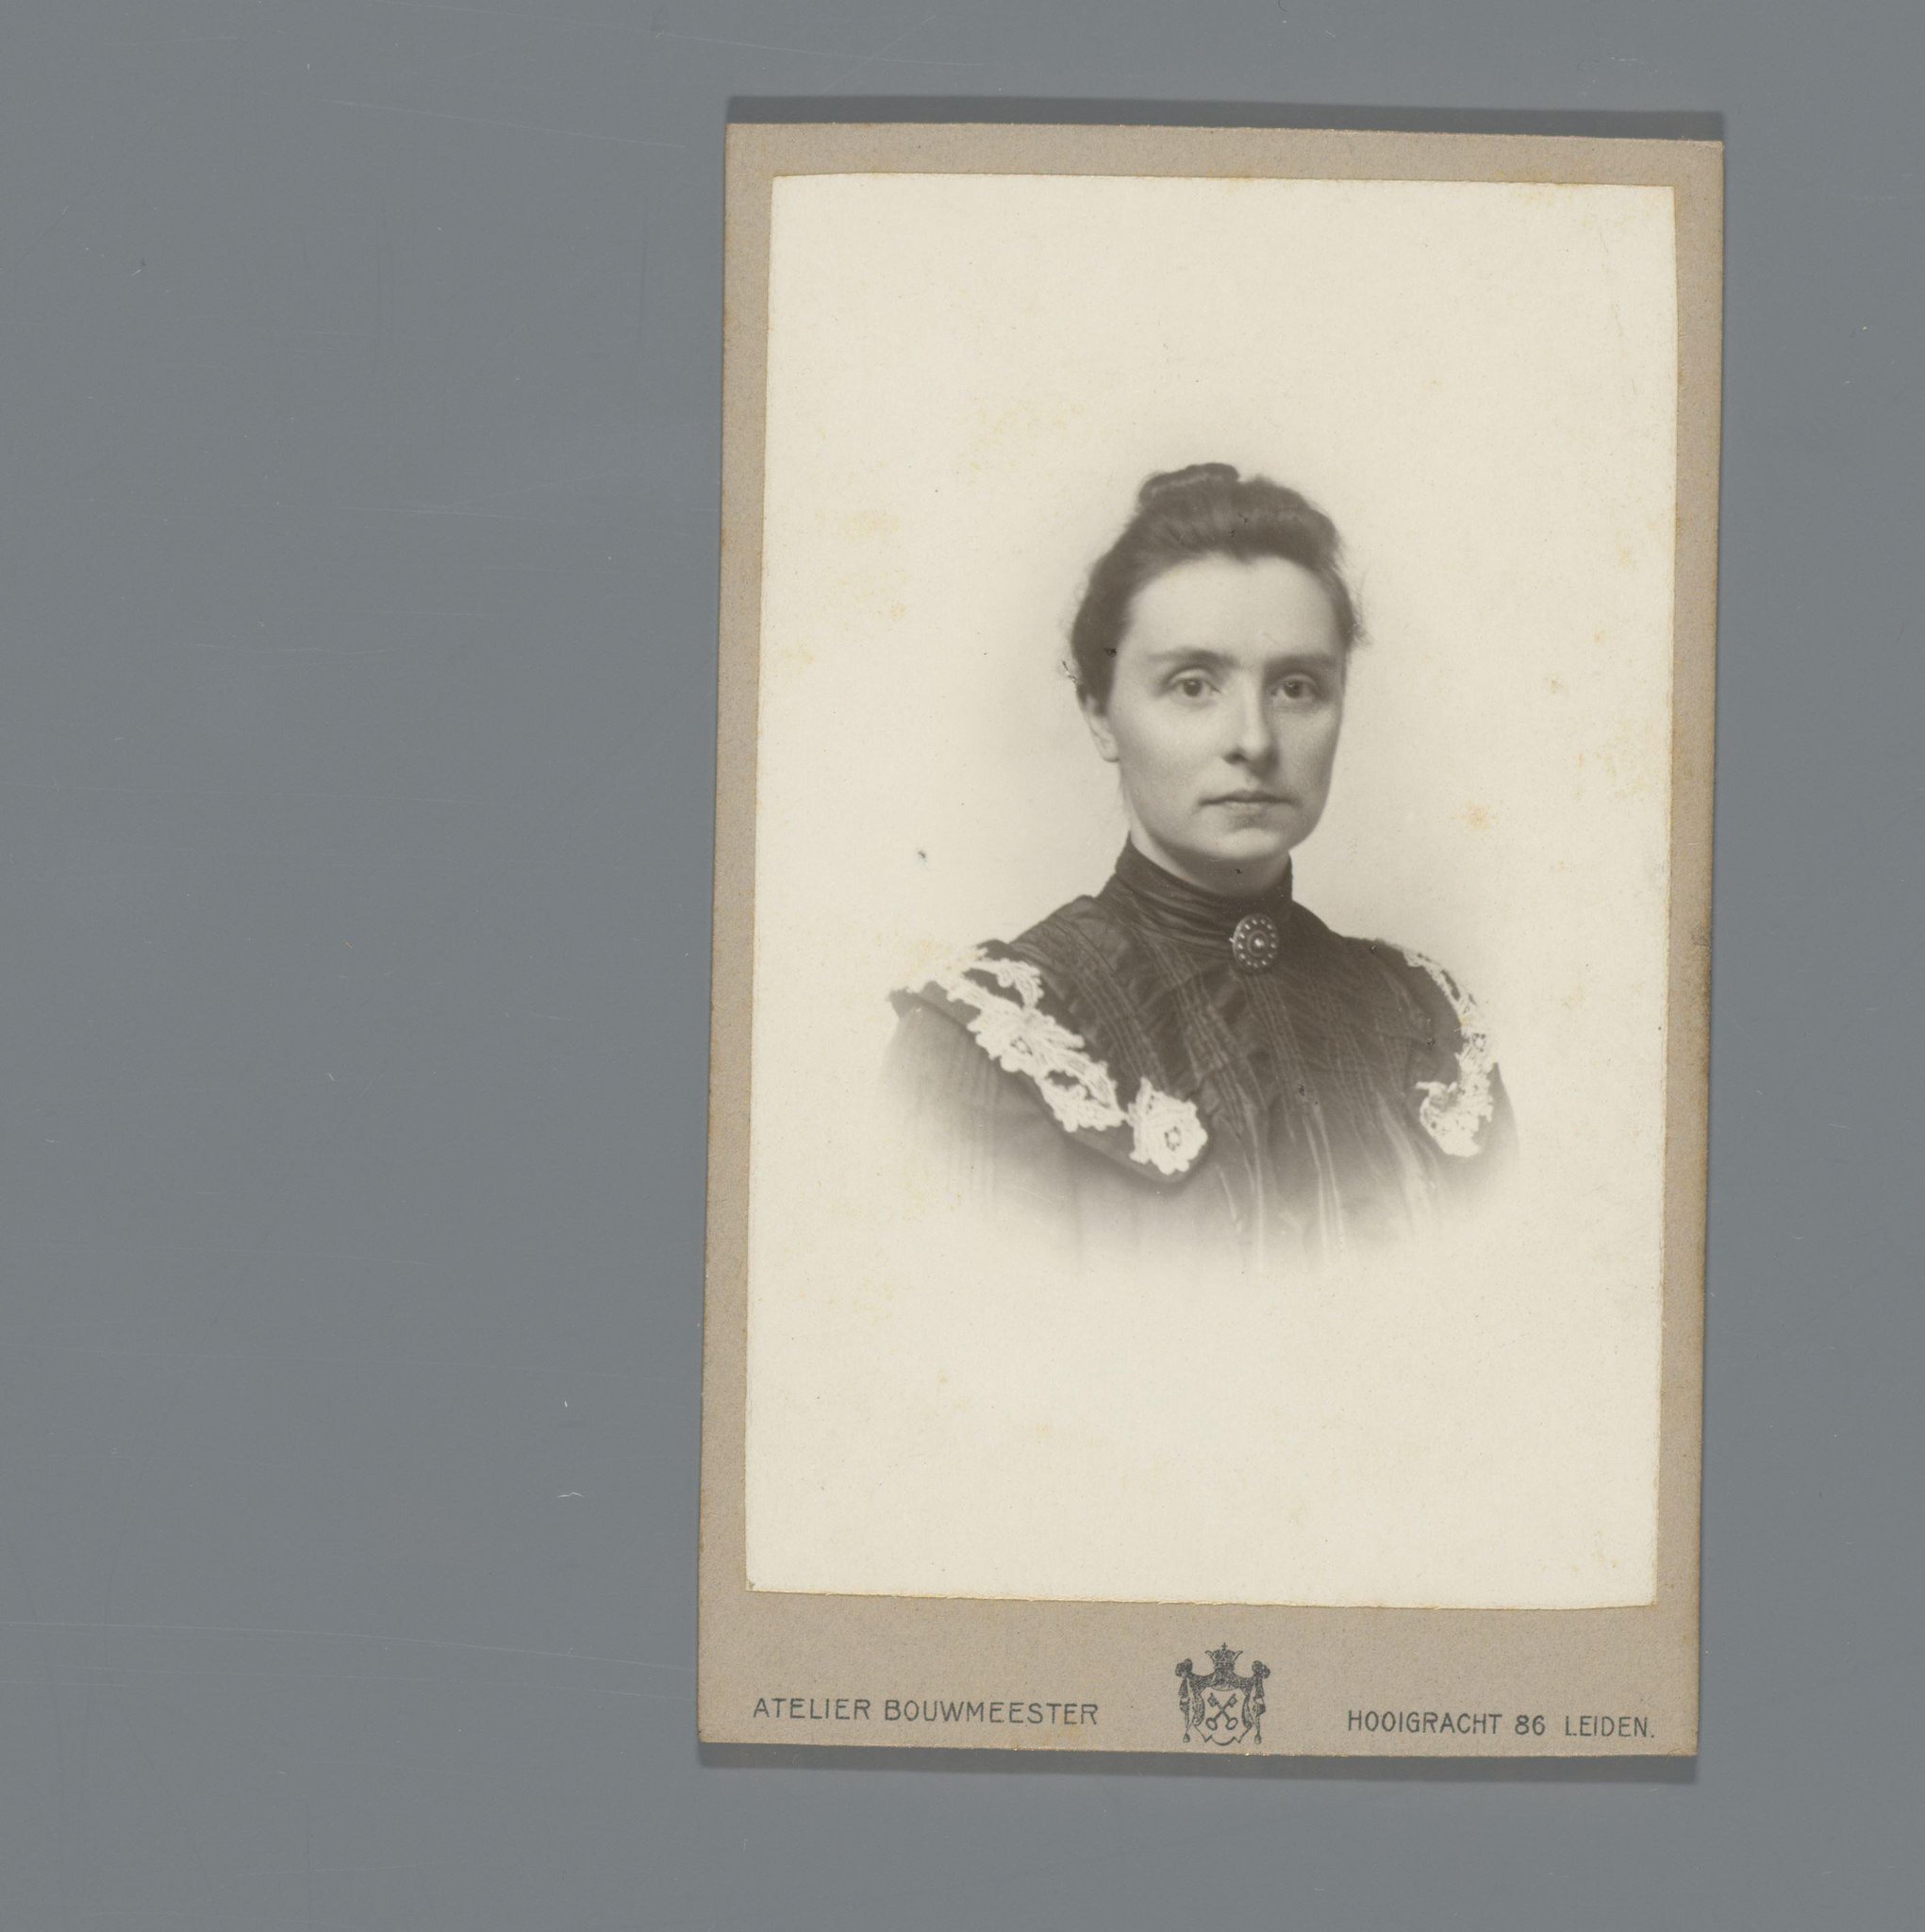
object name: photograph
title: Portret van Anna van Gogh-Kaulbach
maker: thomas johannes bouwmeester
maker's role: fotograaf, retoucheur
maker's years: 1861-1942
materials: cardboard, photographic support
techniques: collodion silver print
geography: leiden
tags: haarlem, portrait of a writer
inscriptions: inscription: ‘ATELIER BOUWMEESTER/ LEIDEN.’, annotation: ‘A. van Gogh-Kaulbach’, inscription: ‘ATELIER BOUWMEESTER HOOIGRACHT 86 LEIDEN’, collector's mark: Lugt 2228a, :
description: Foto gebruikt als auteursportret in: De Hollandsche Lelie, november 1903.